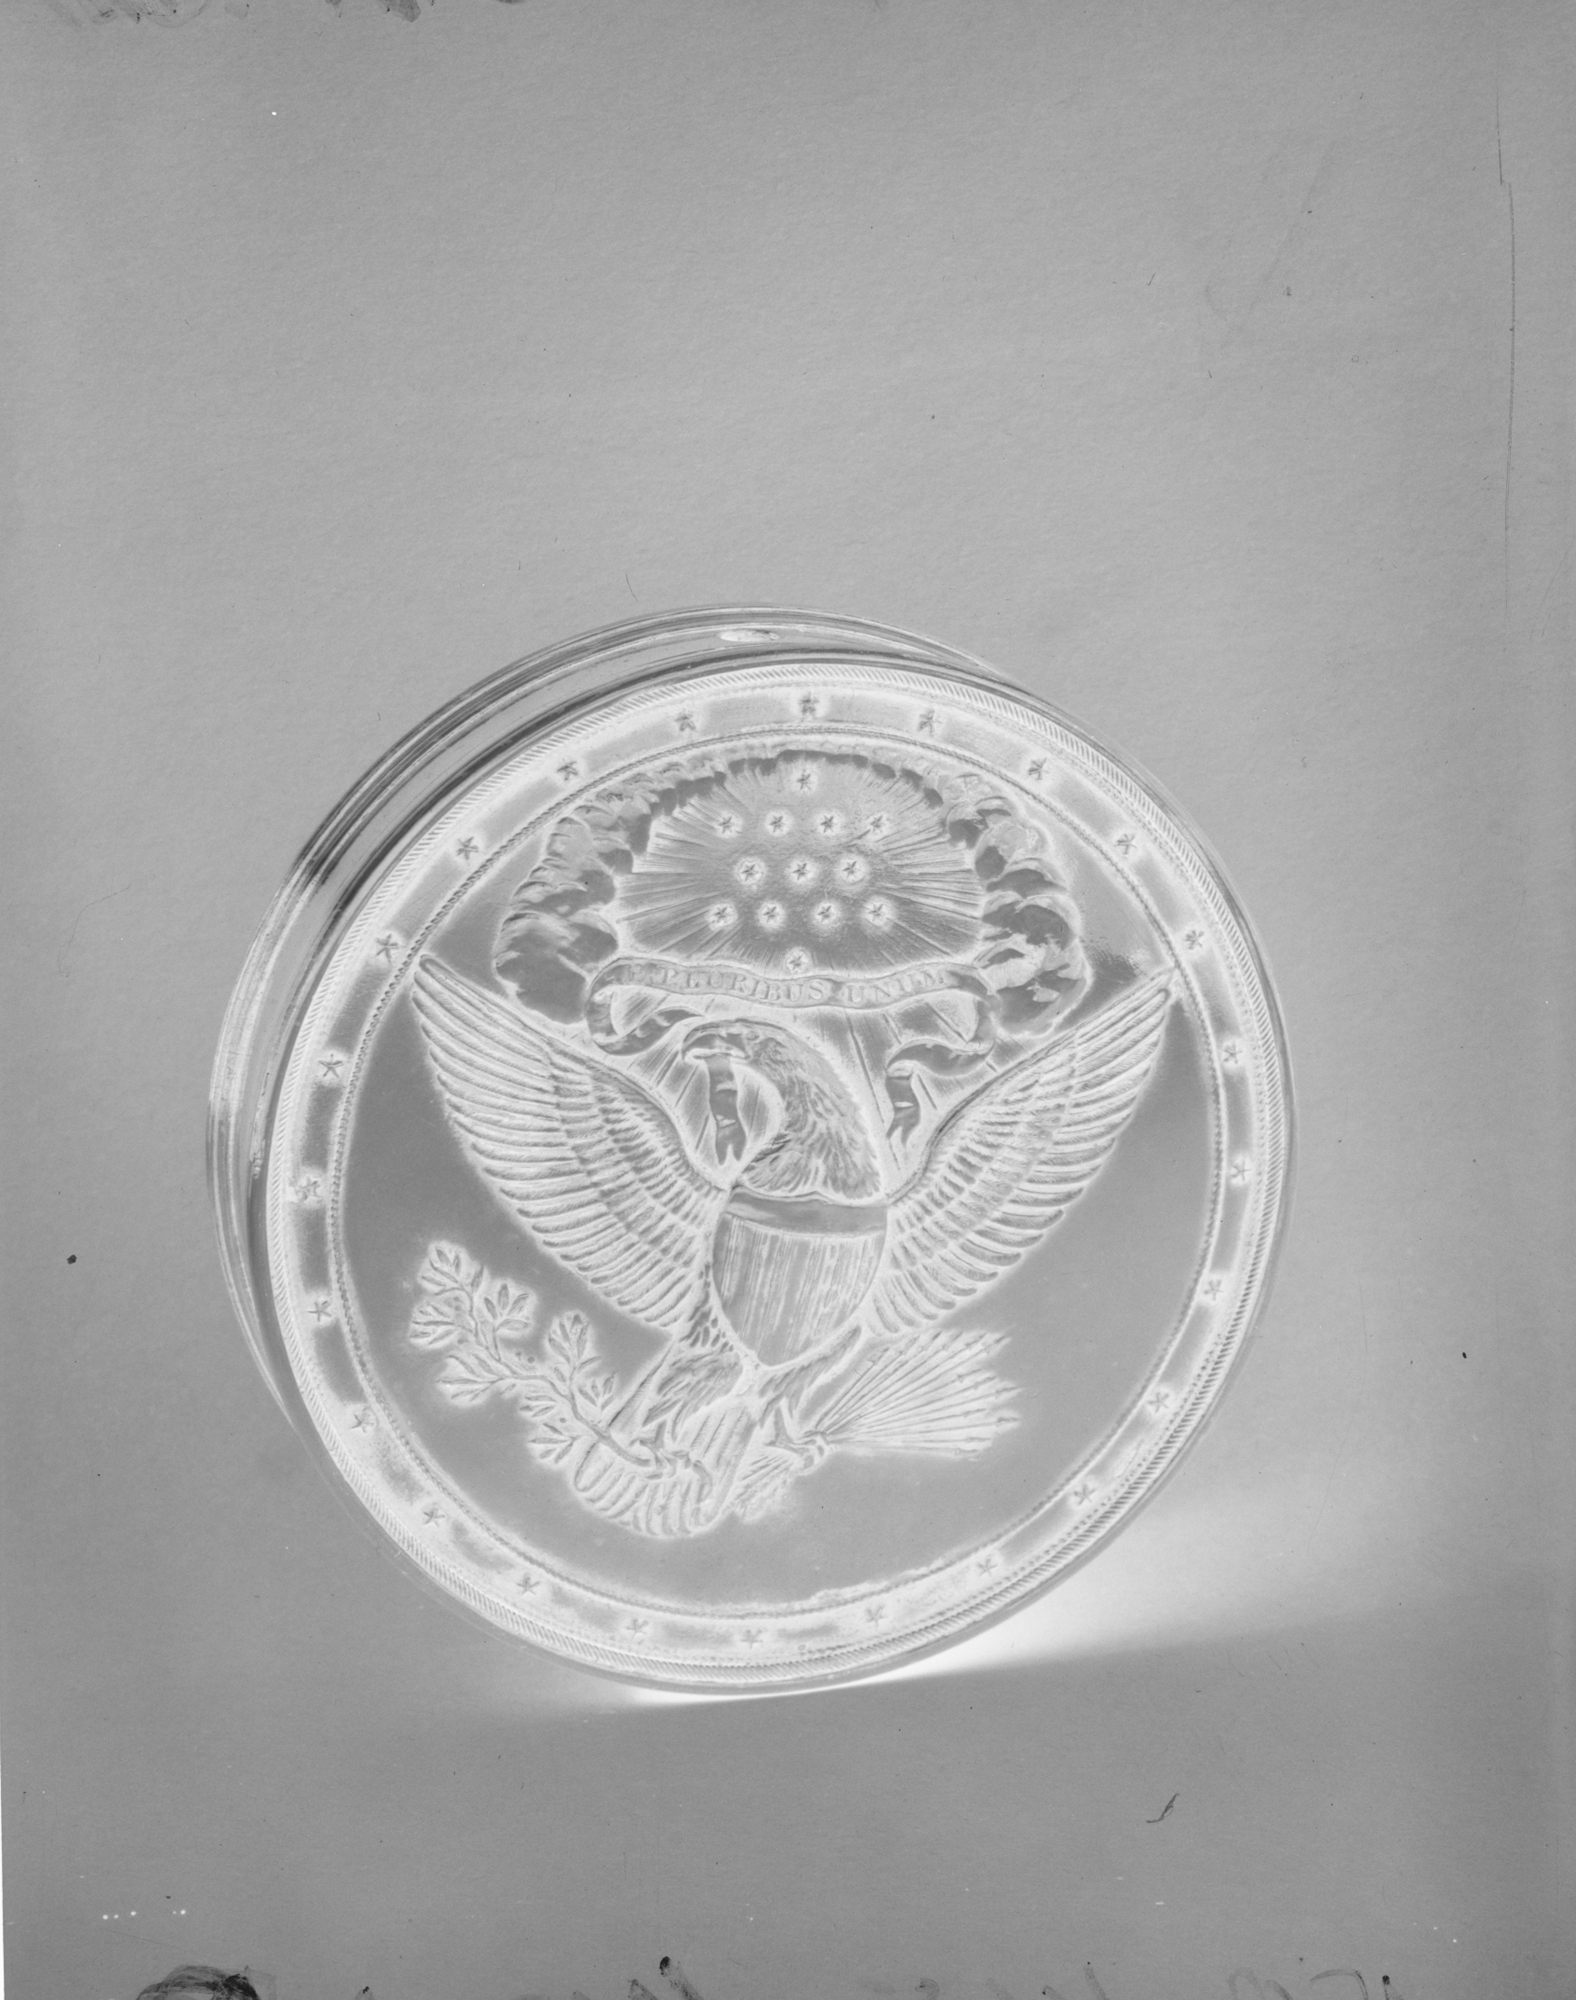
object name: skippet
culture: american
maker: seraphim masi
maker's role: maker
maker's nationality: american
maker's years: 1819-1852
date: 1825-1852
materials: silver, silver gilt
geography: united states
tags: eagles